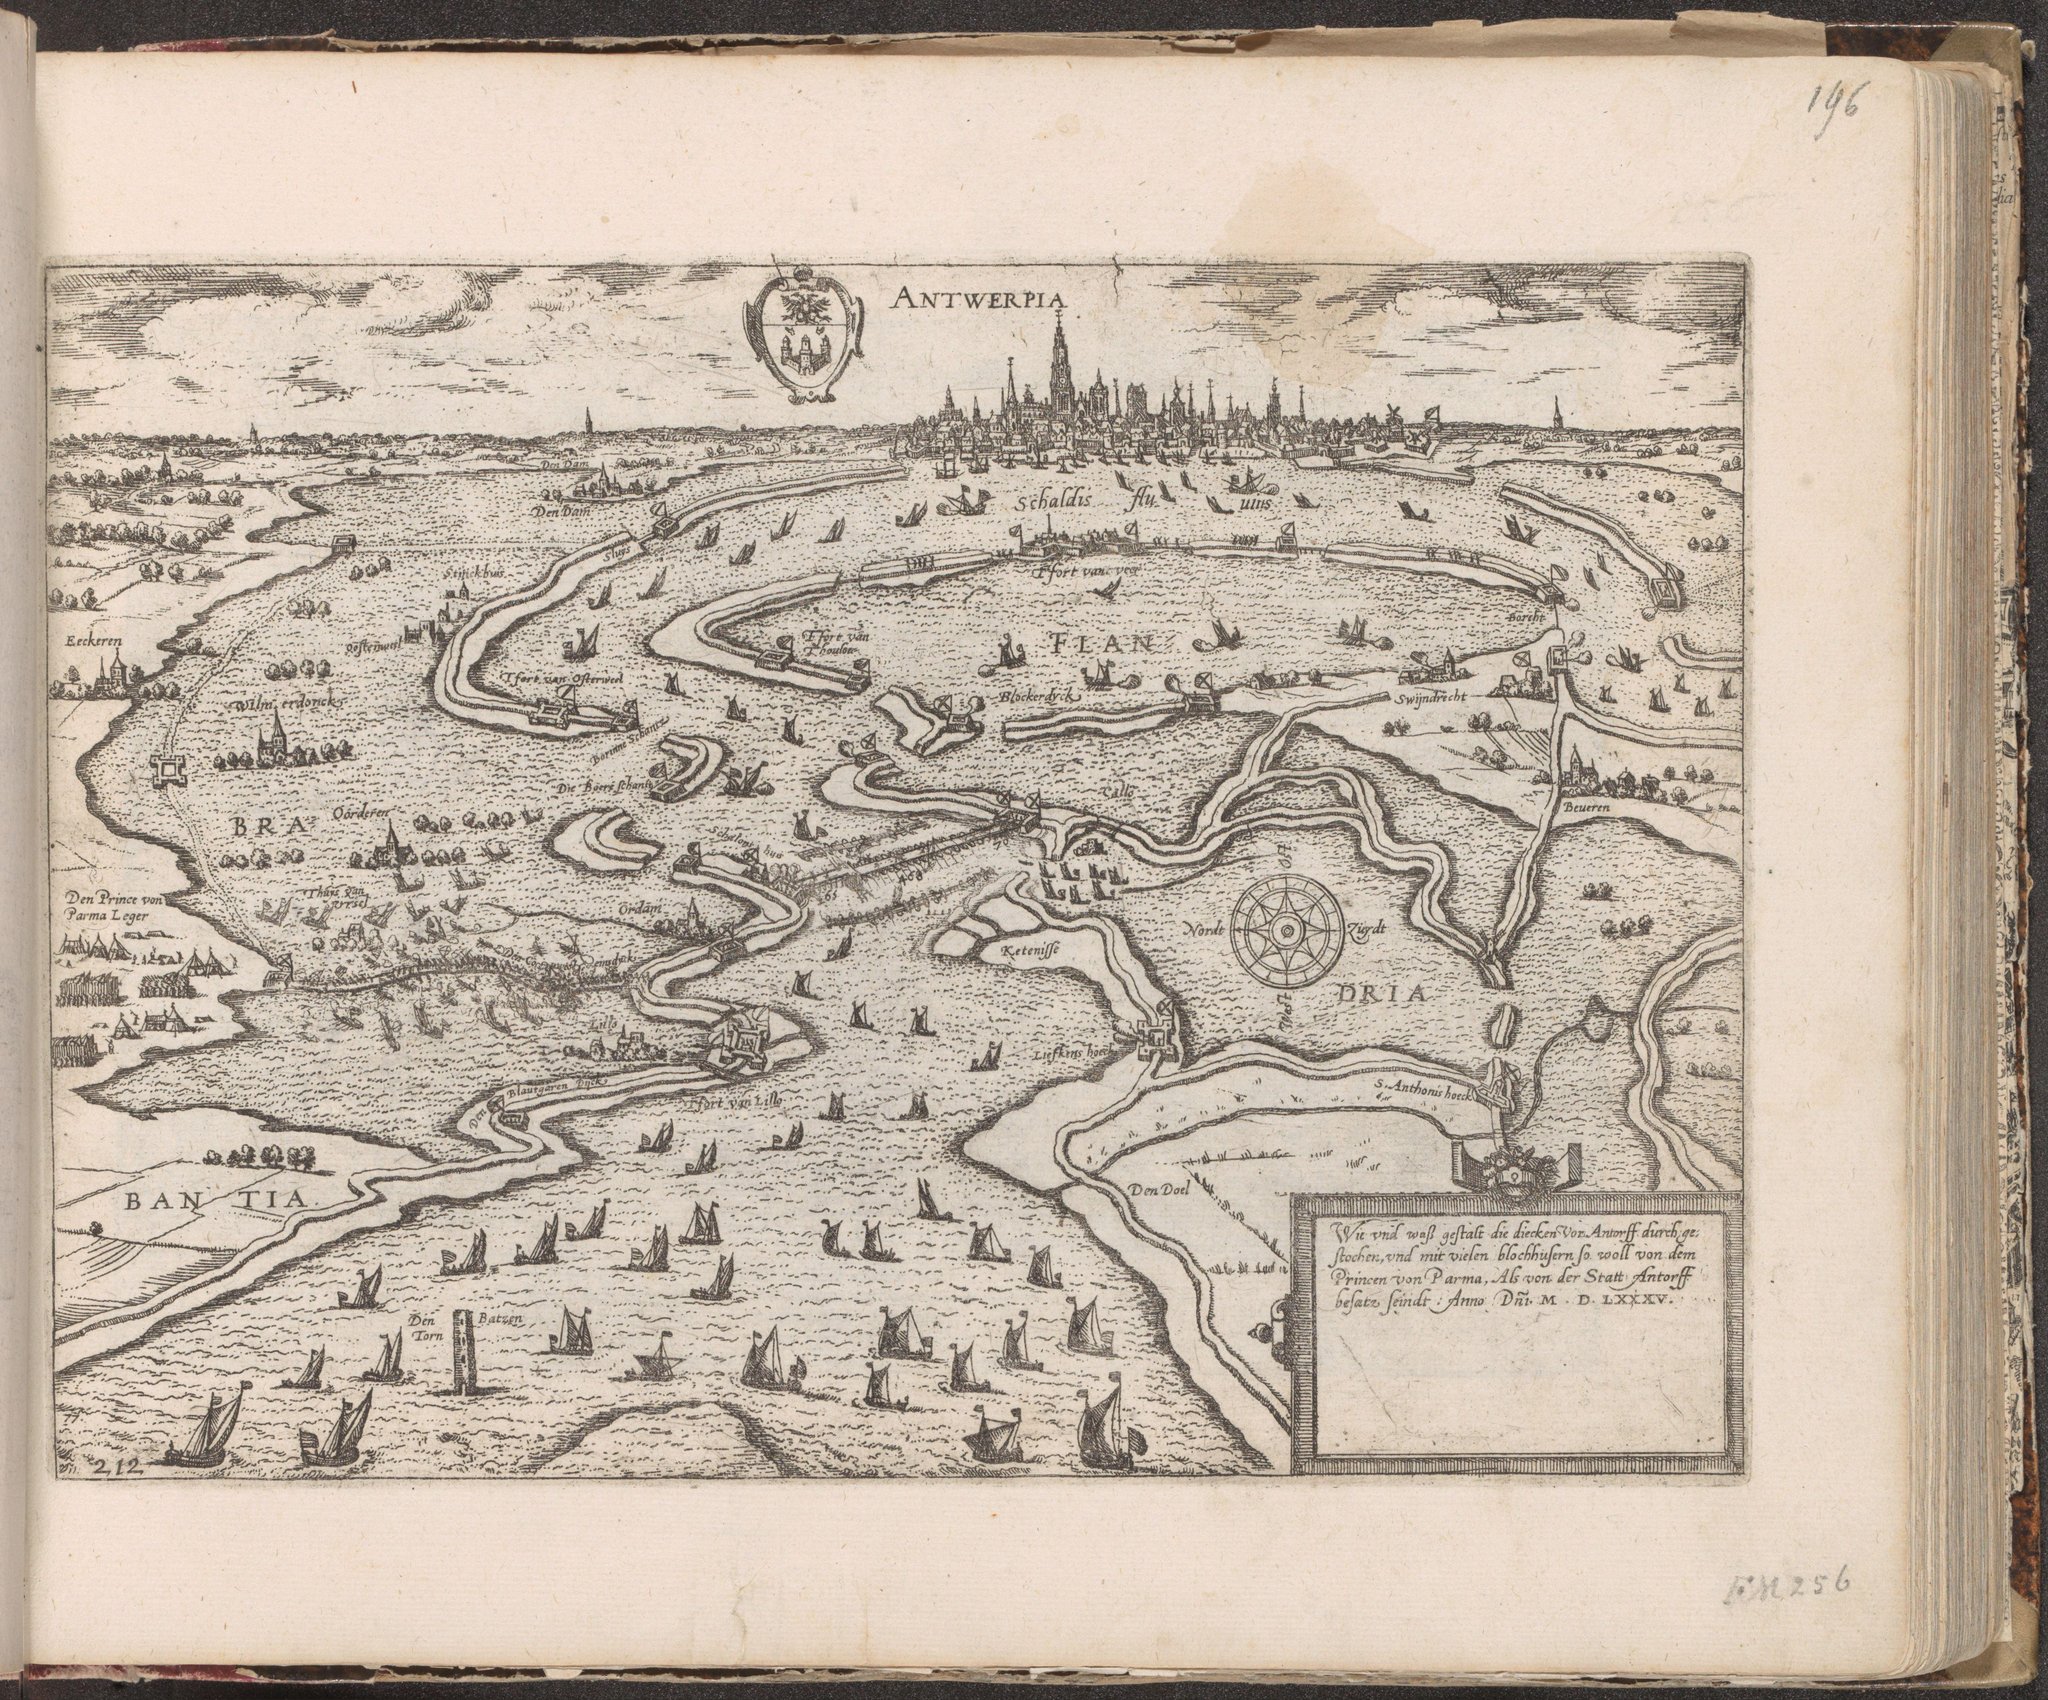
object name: print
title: Dijken doorgestoken bij Antwerpen, 1585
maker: frans hogenberg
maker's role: print maker, publisher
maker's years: 1538-1590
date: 1587-1591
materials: paper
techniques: etching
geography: cologne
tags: dike-break, battle, fighting in general, antwerp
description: Dijken doorgestoken bij Antwerpen, 26 mei 1585. Gezicht op het ondergelopen gebied rond de stad Antwerpen en de strijd om de Kauwensteinse dijk tussen het leger van Parma en het Staatse leger tijdens het beleg van Antwerpen. Met onderschrift van 4 regels in het Duits in een cartouche. Linksonder genummerd: 212. De prent maakt deel uit van een album.